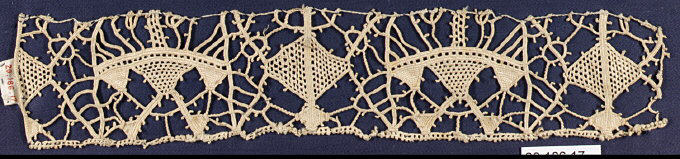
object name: strip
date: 1501-1600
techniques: lace